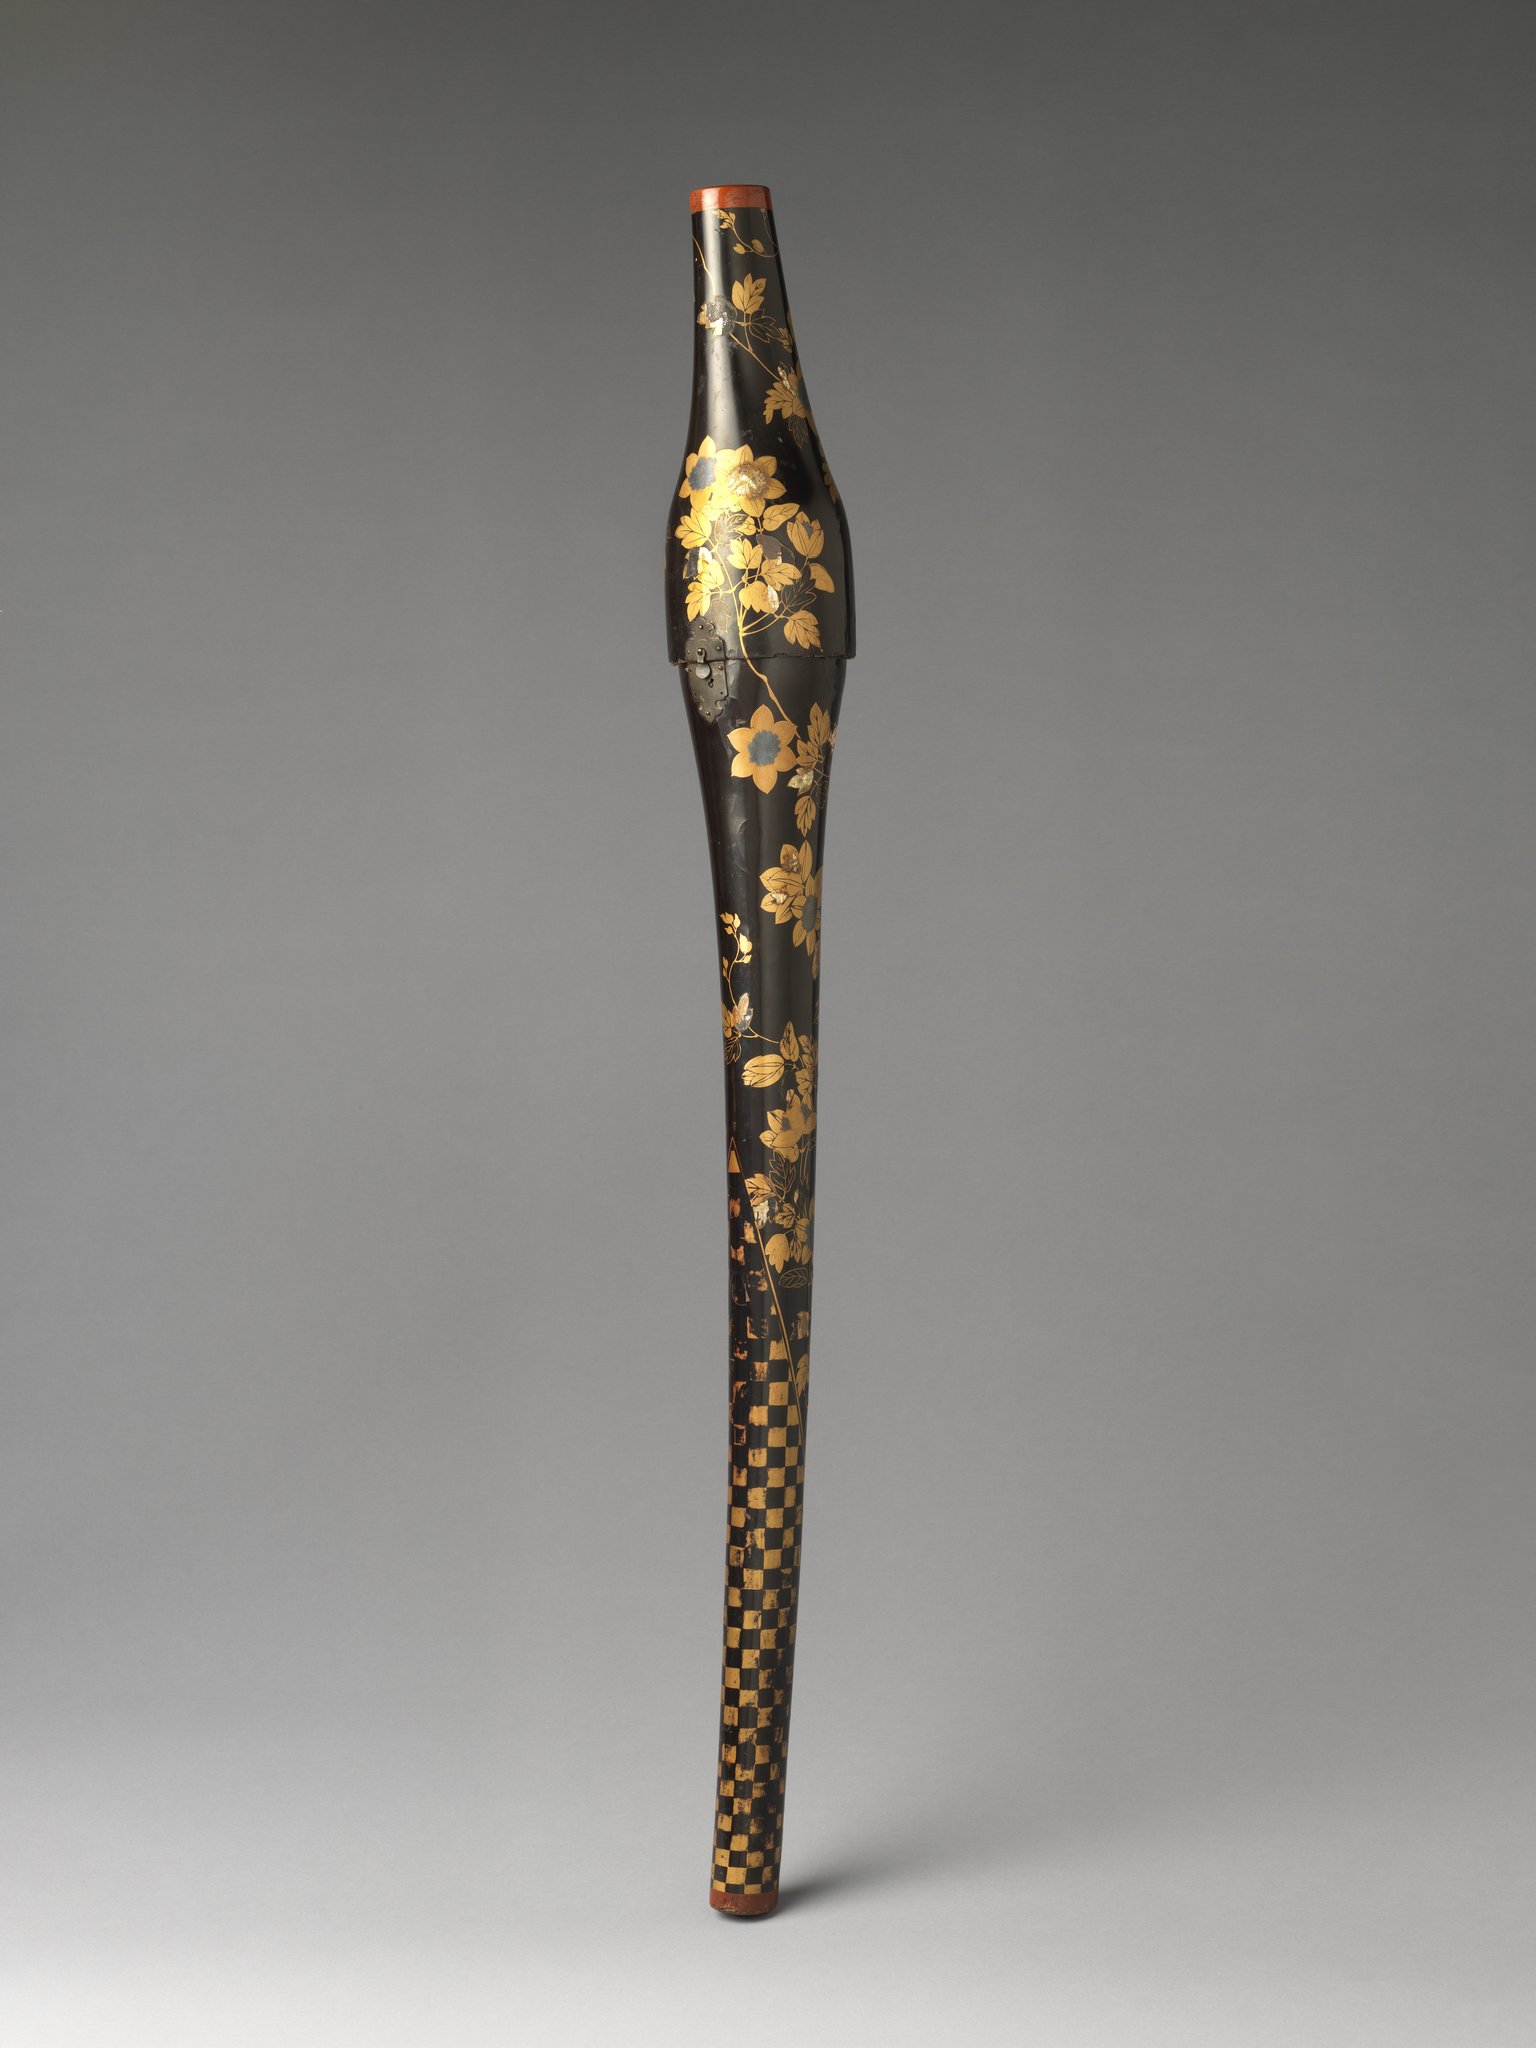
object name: sword case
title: Sword Case (Katana-tsutsu) with Clematis and Checkered Pattern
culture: japanese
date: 1601-1700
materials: foil, gold, lacquer, mother of pearl, silver, wood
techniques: hiramakie, inlay, lacquer